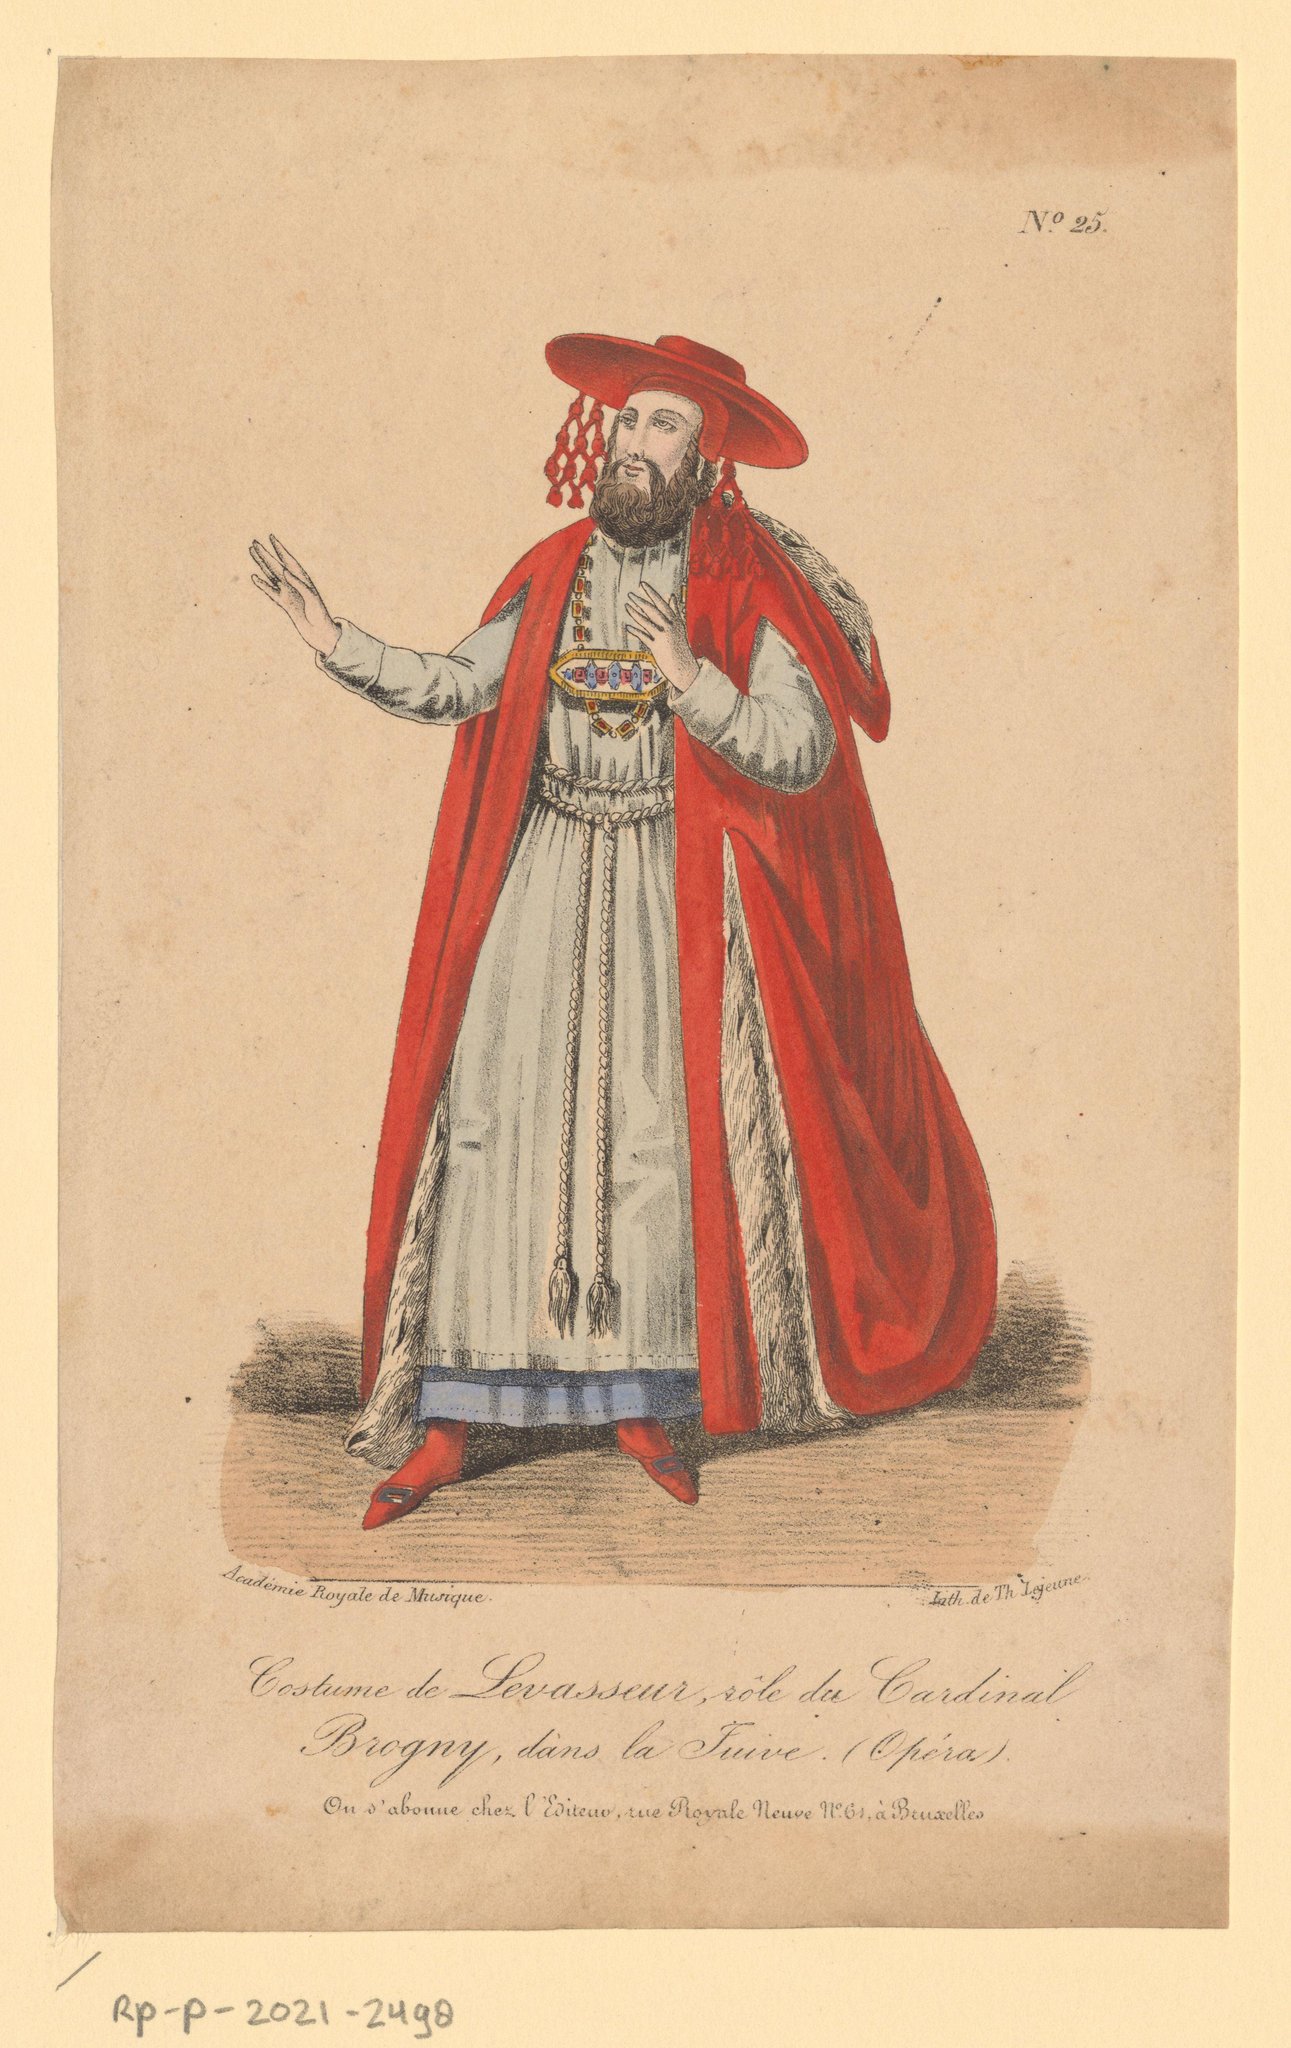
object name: print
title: Costume de Levasseur, rôle du Cardinal Brogny, dans la Juive (Opéra)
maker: Anonymous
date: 1835-1850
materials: paper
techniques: hand coloring, lithograph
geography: brussels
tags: historical persons, historical costume, portrait of opera-singer, insignia of cardinal, e.g. hat, mantle